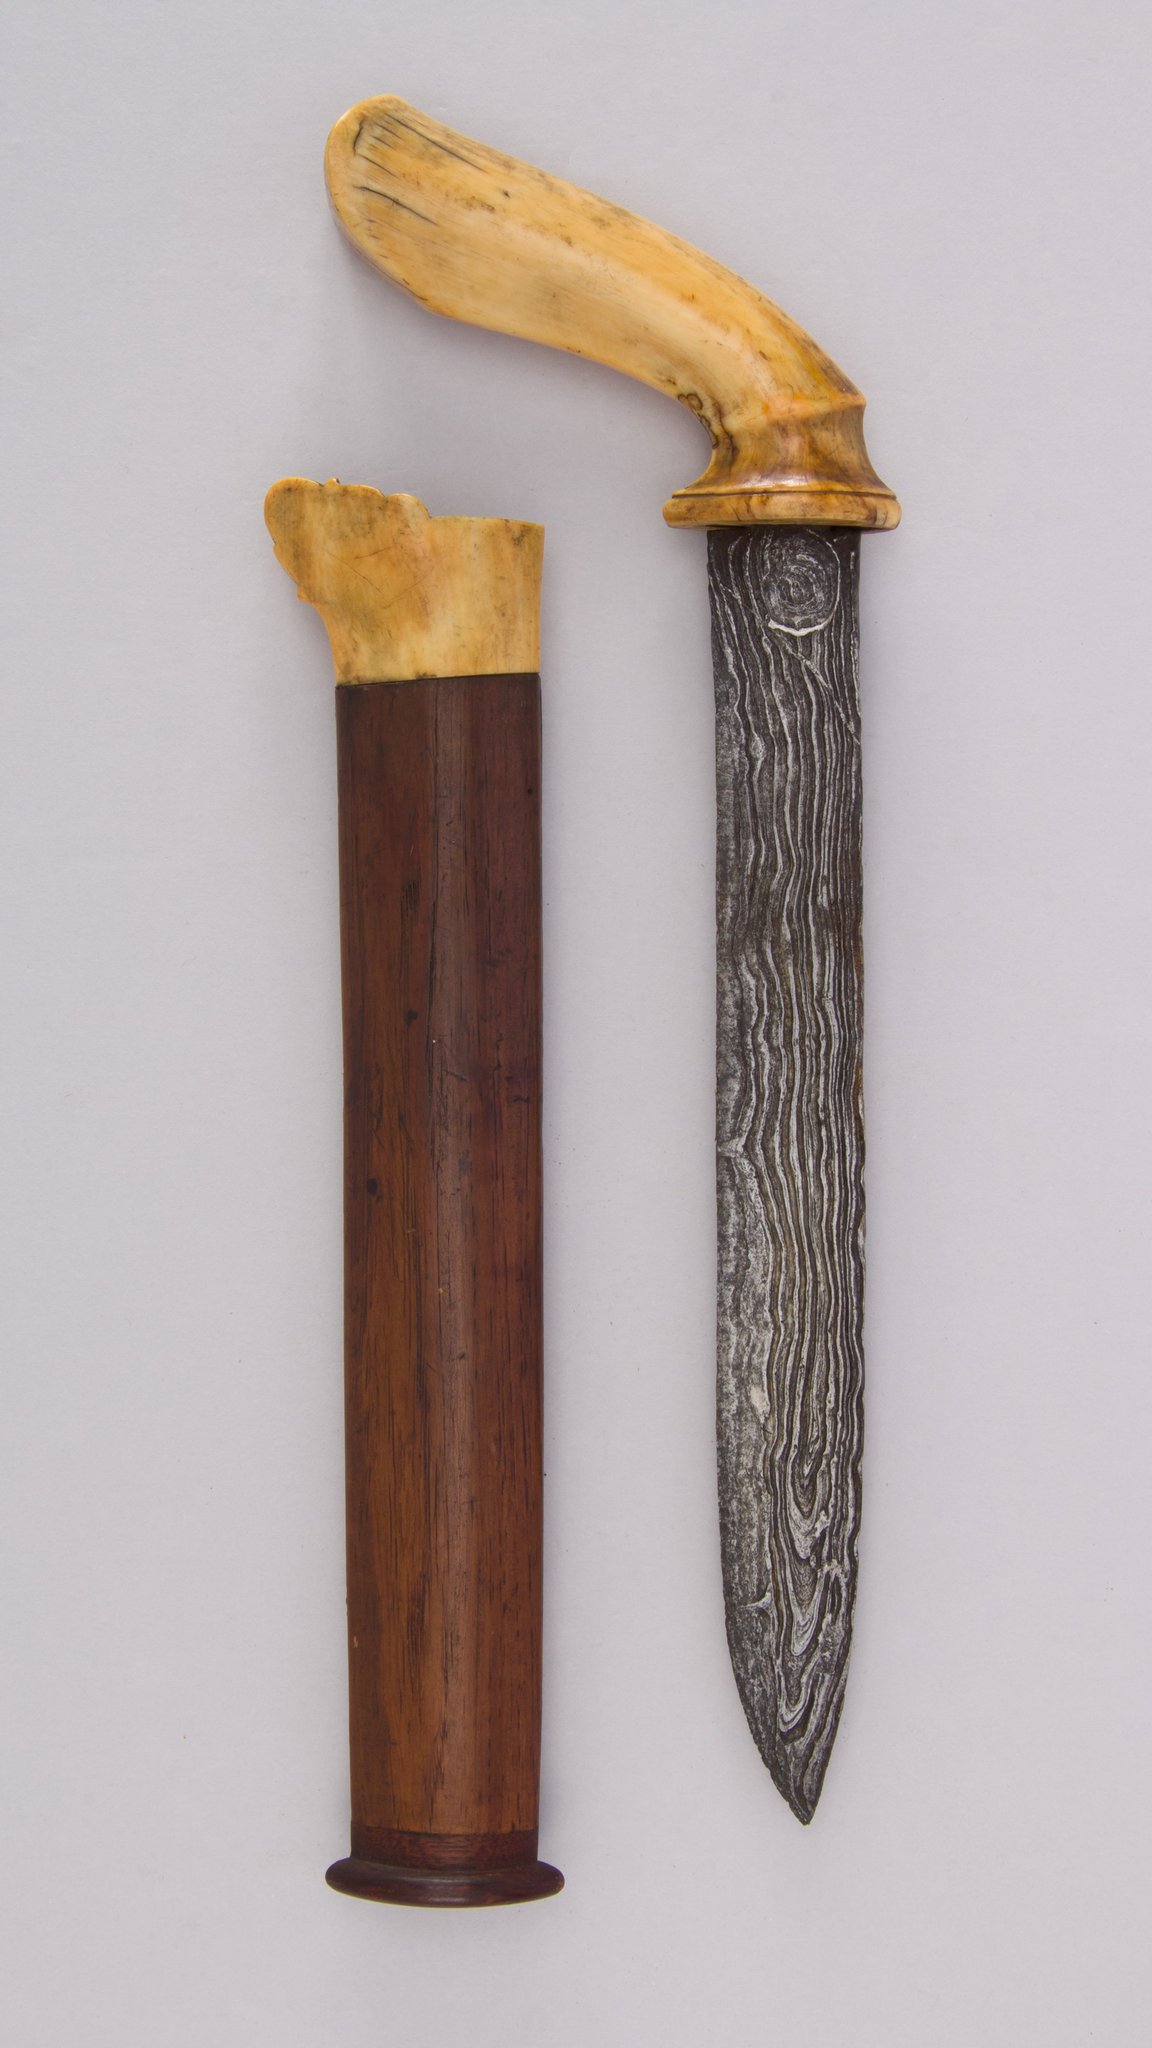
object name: knife with sheath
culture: malayan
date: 1701-1900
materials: ivory, wood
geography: malaysia